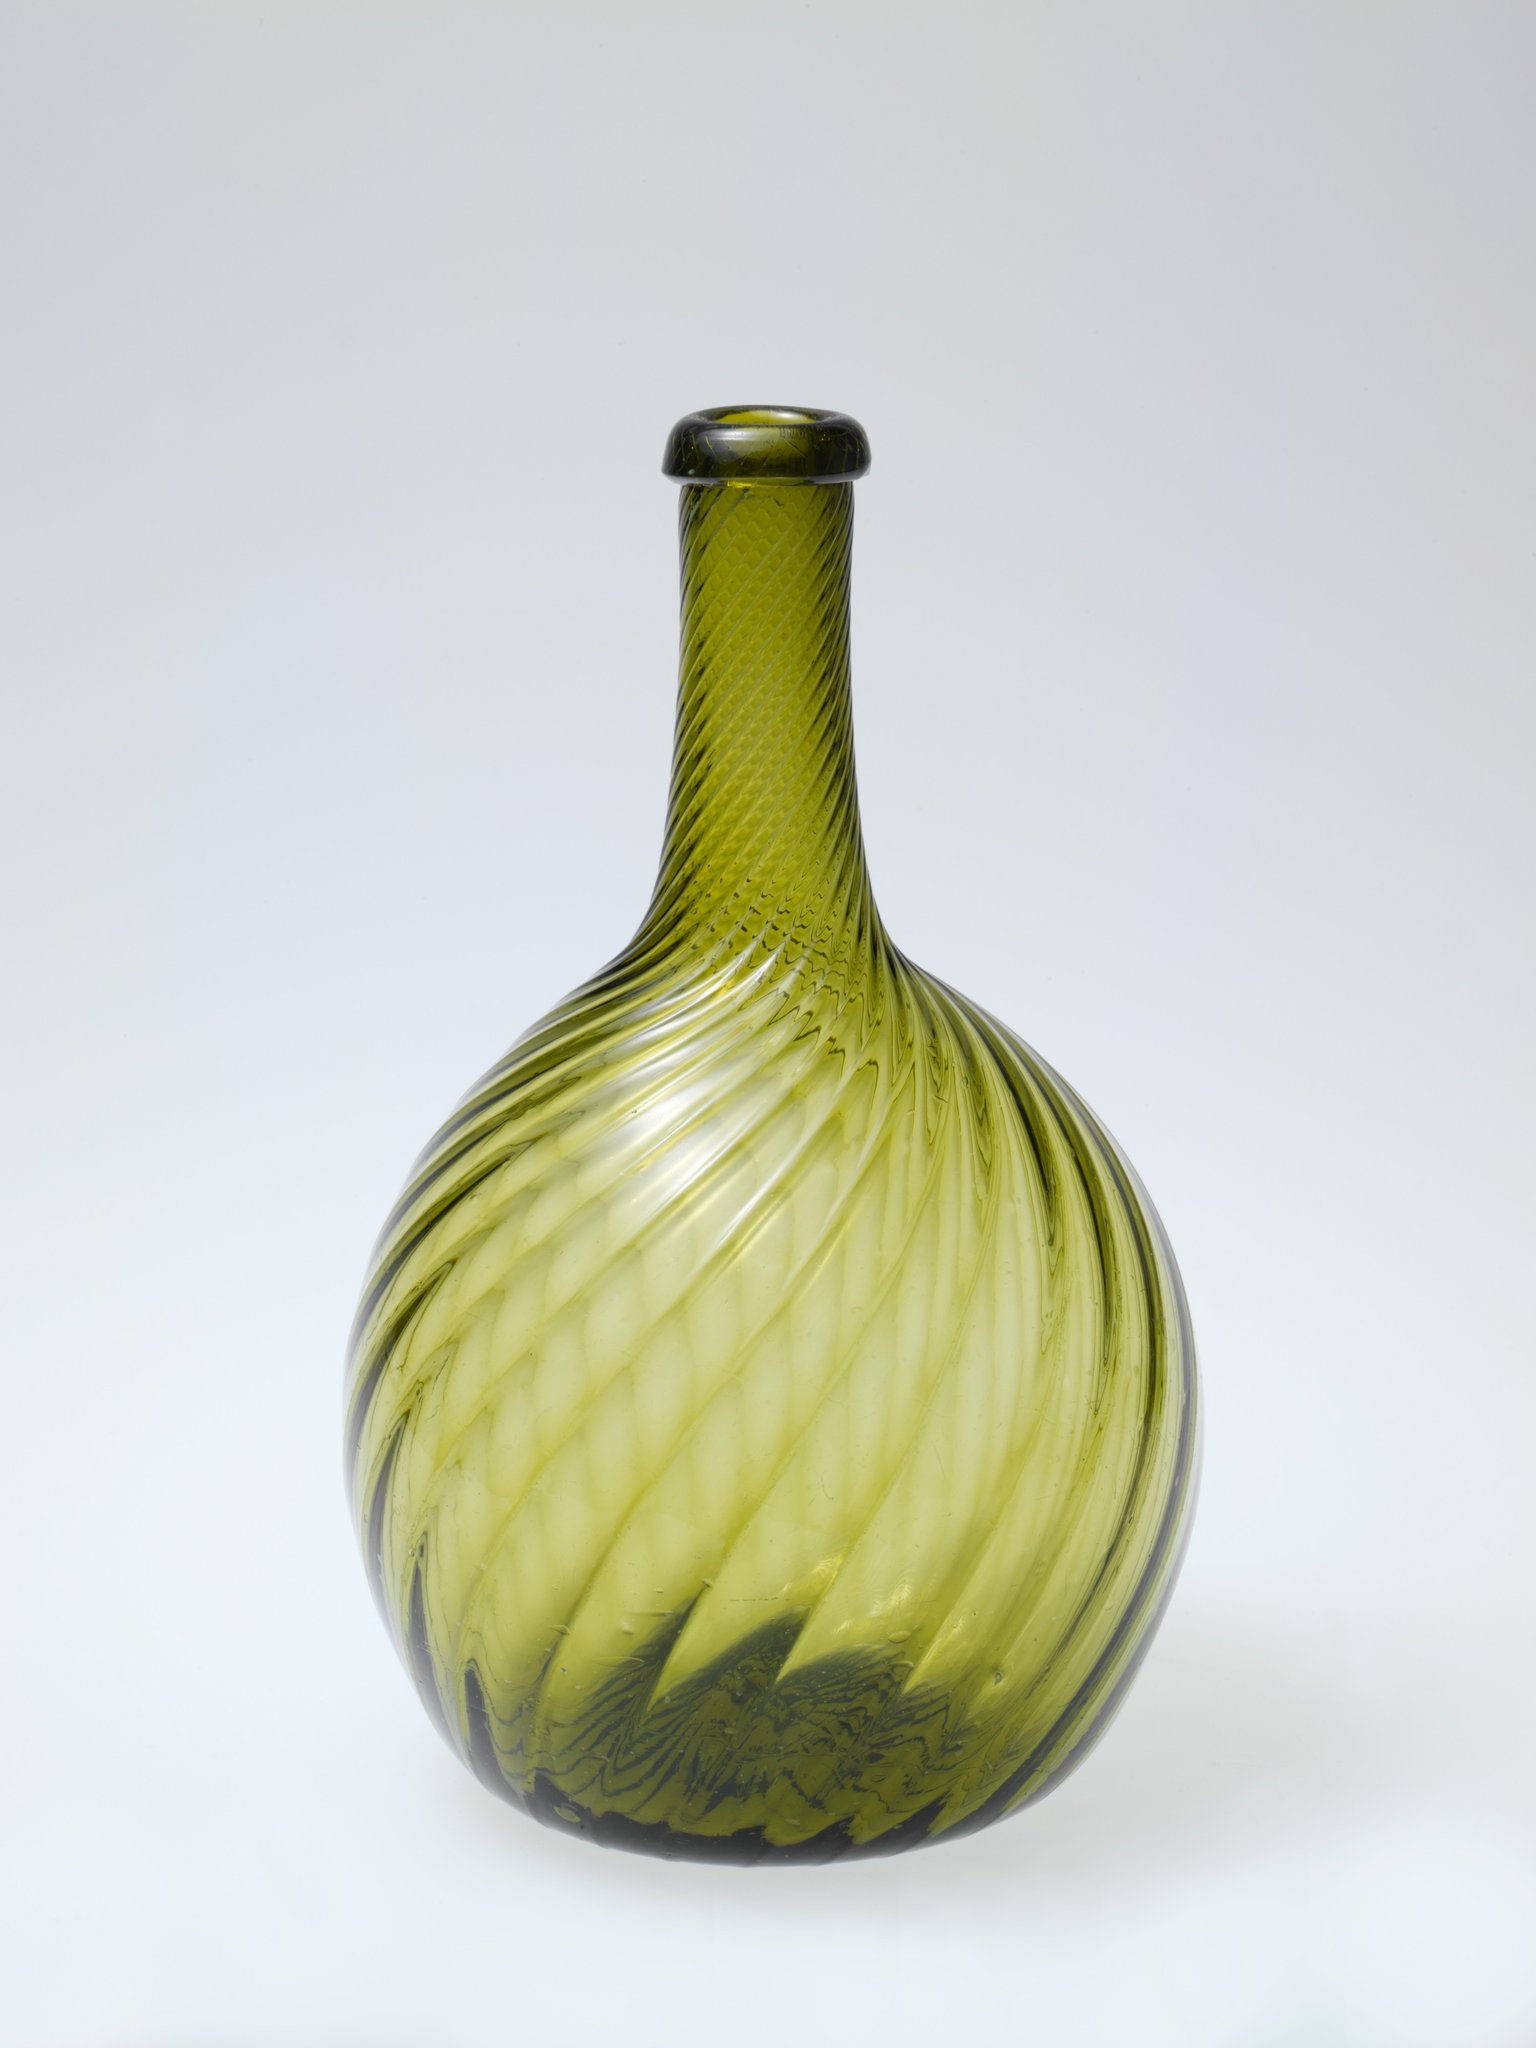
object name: bottle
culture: american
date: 1815-1845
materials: amber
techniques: molding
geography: united states